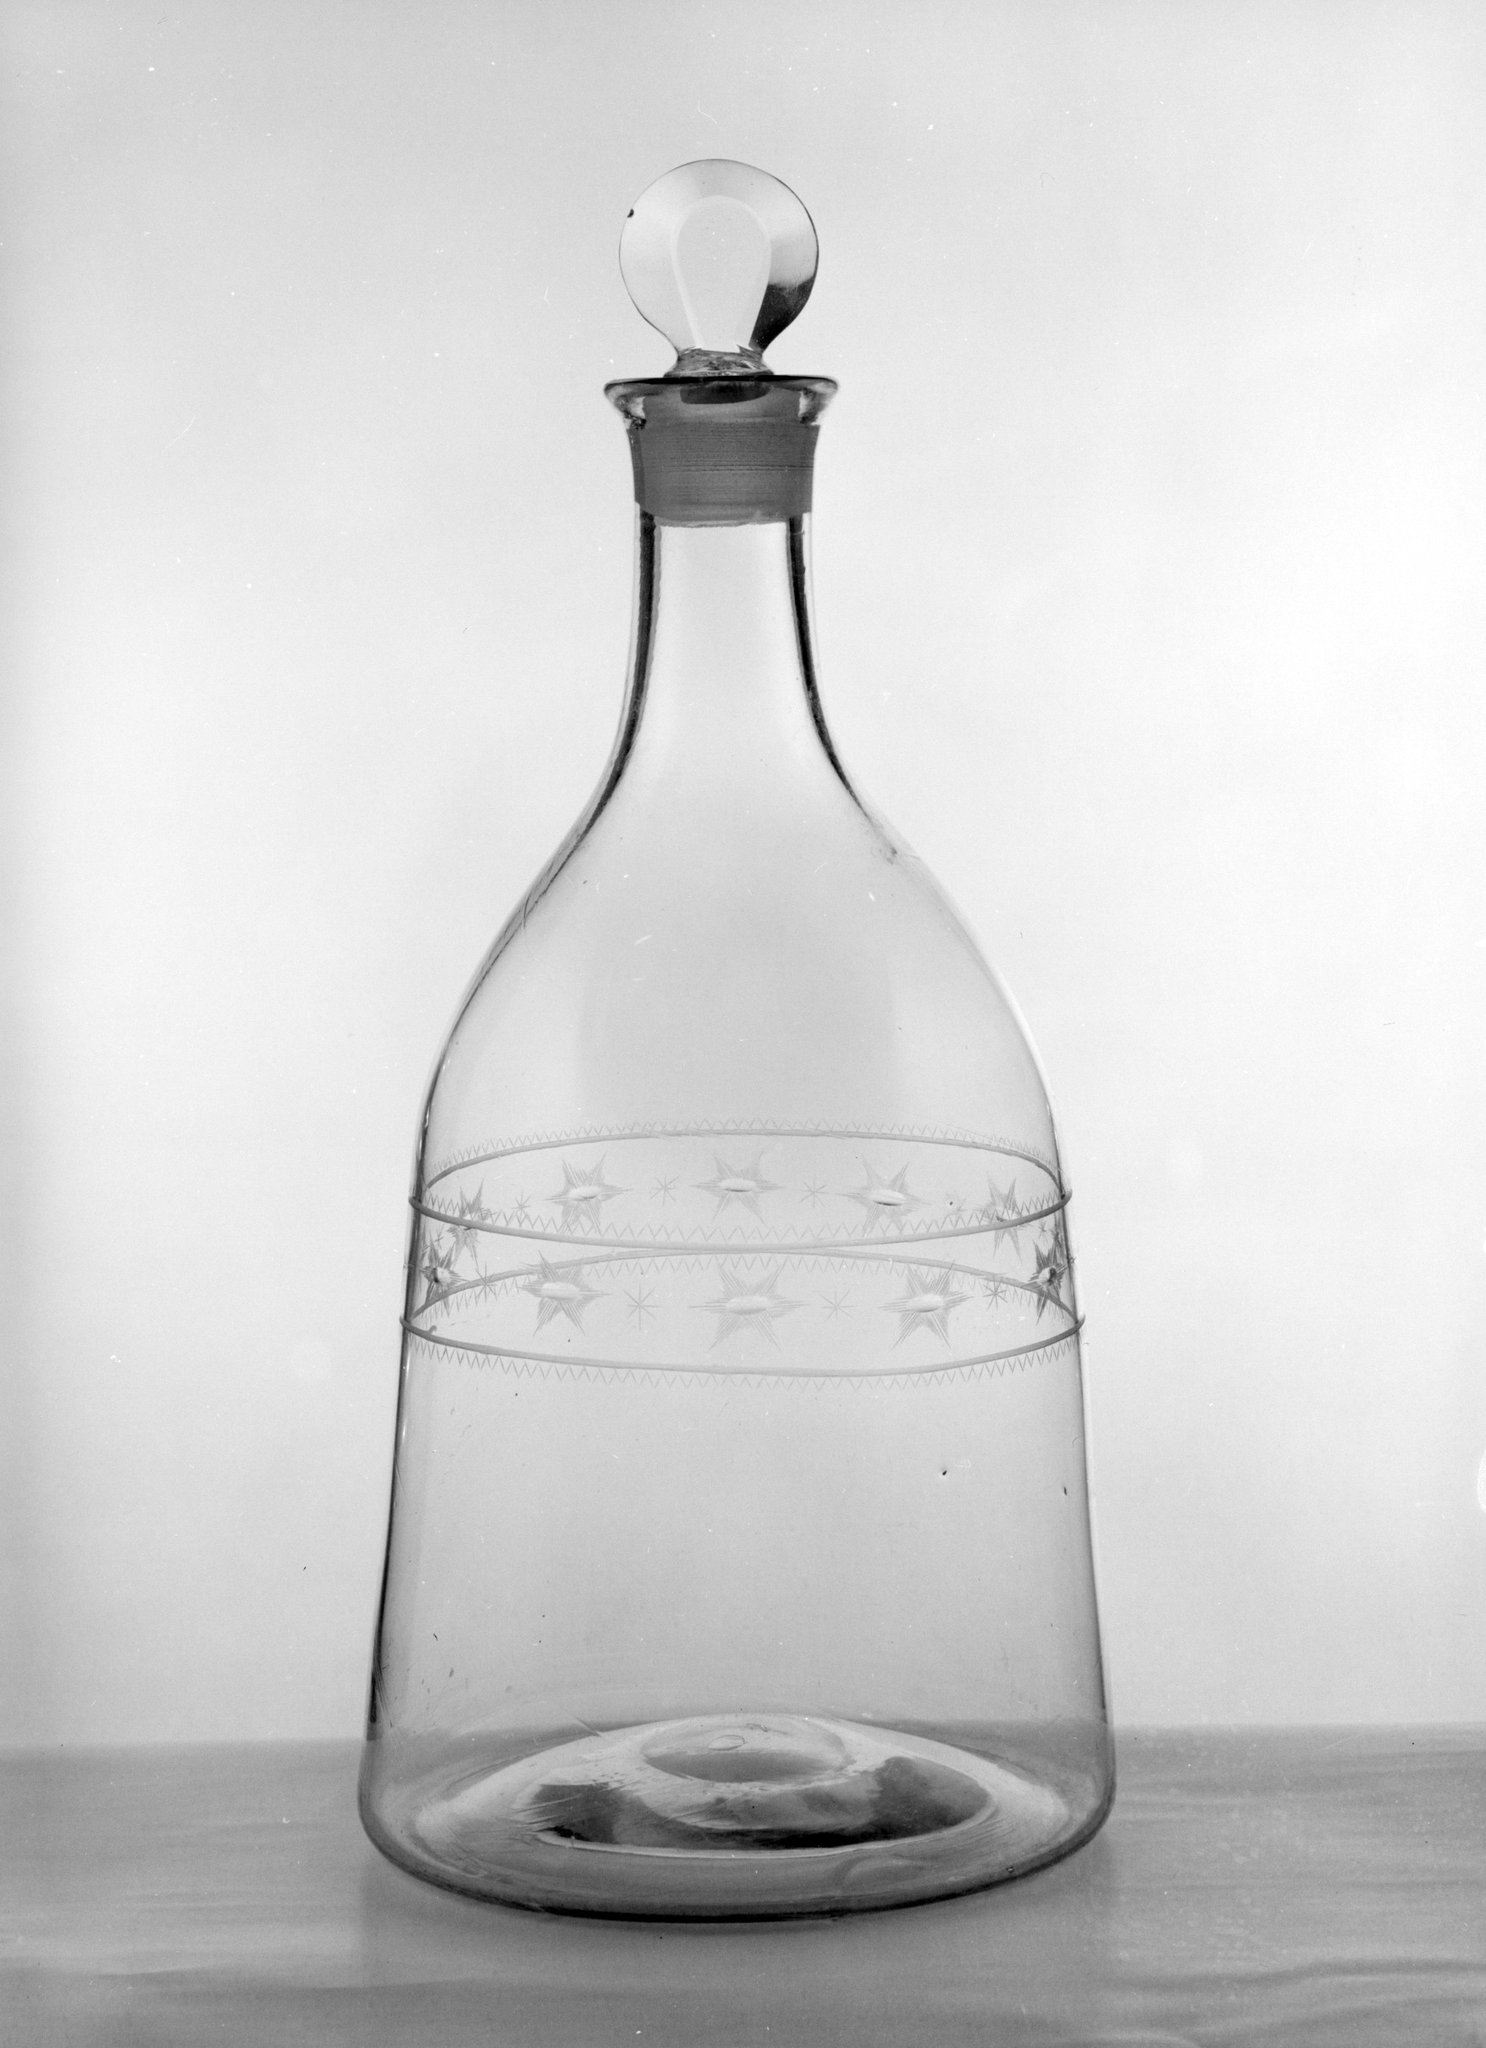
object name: decanter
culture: american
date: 1800-1830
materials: glass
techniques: glassblowing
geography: united states